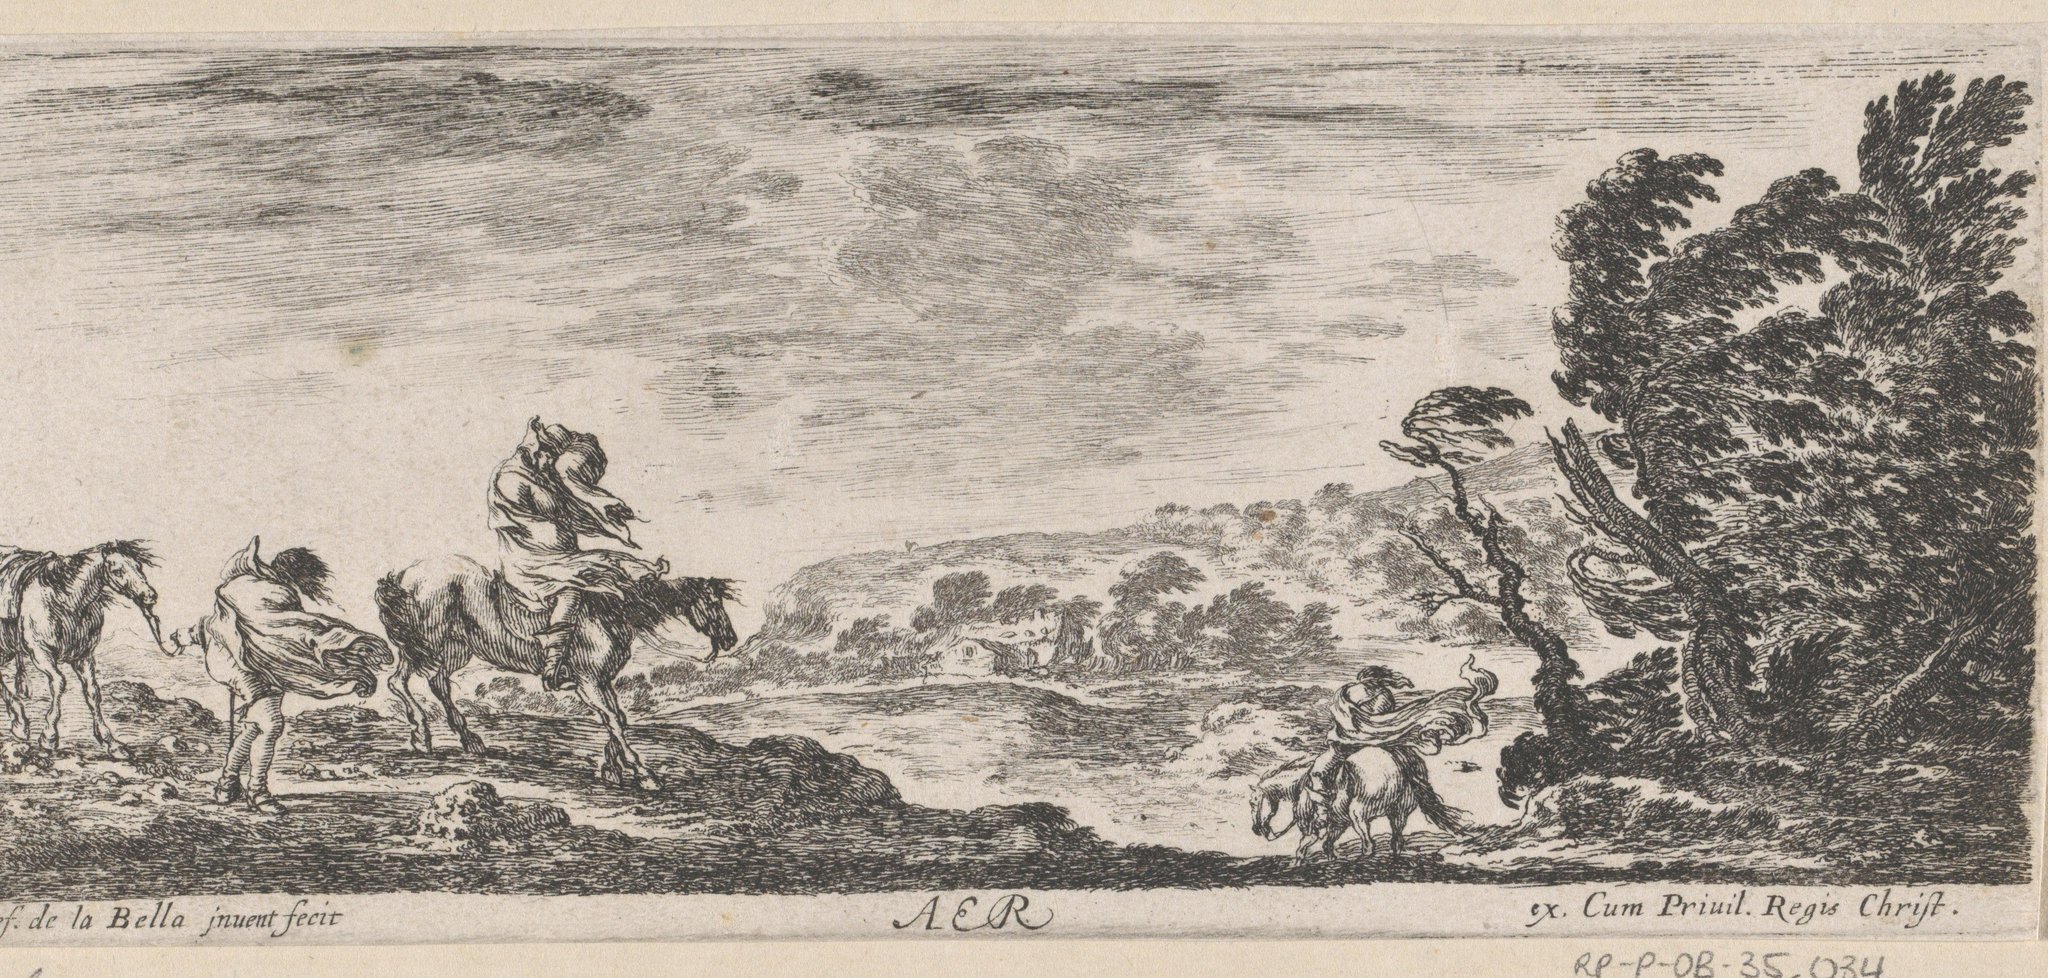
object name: print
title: De vier elementen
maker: stefano della bella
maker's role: draughtsman, print maker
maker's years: 1610-1664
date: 1620-1664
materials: paper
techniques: etching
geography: france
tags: riding a horse, ass, or mule; rider, horseman, landscapes, winds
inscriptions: collector's mark: Lugt 240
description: Een landschap met harde wind. Op de voorgrond drie mannen met paarden die moeite hebben tegen de wind in te rijden.